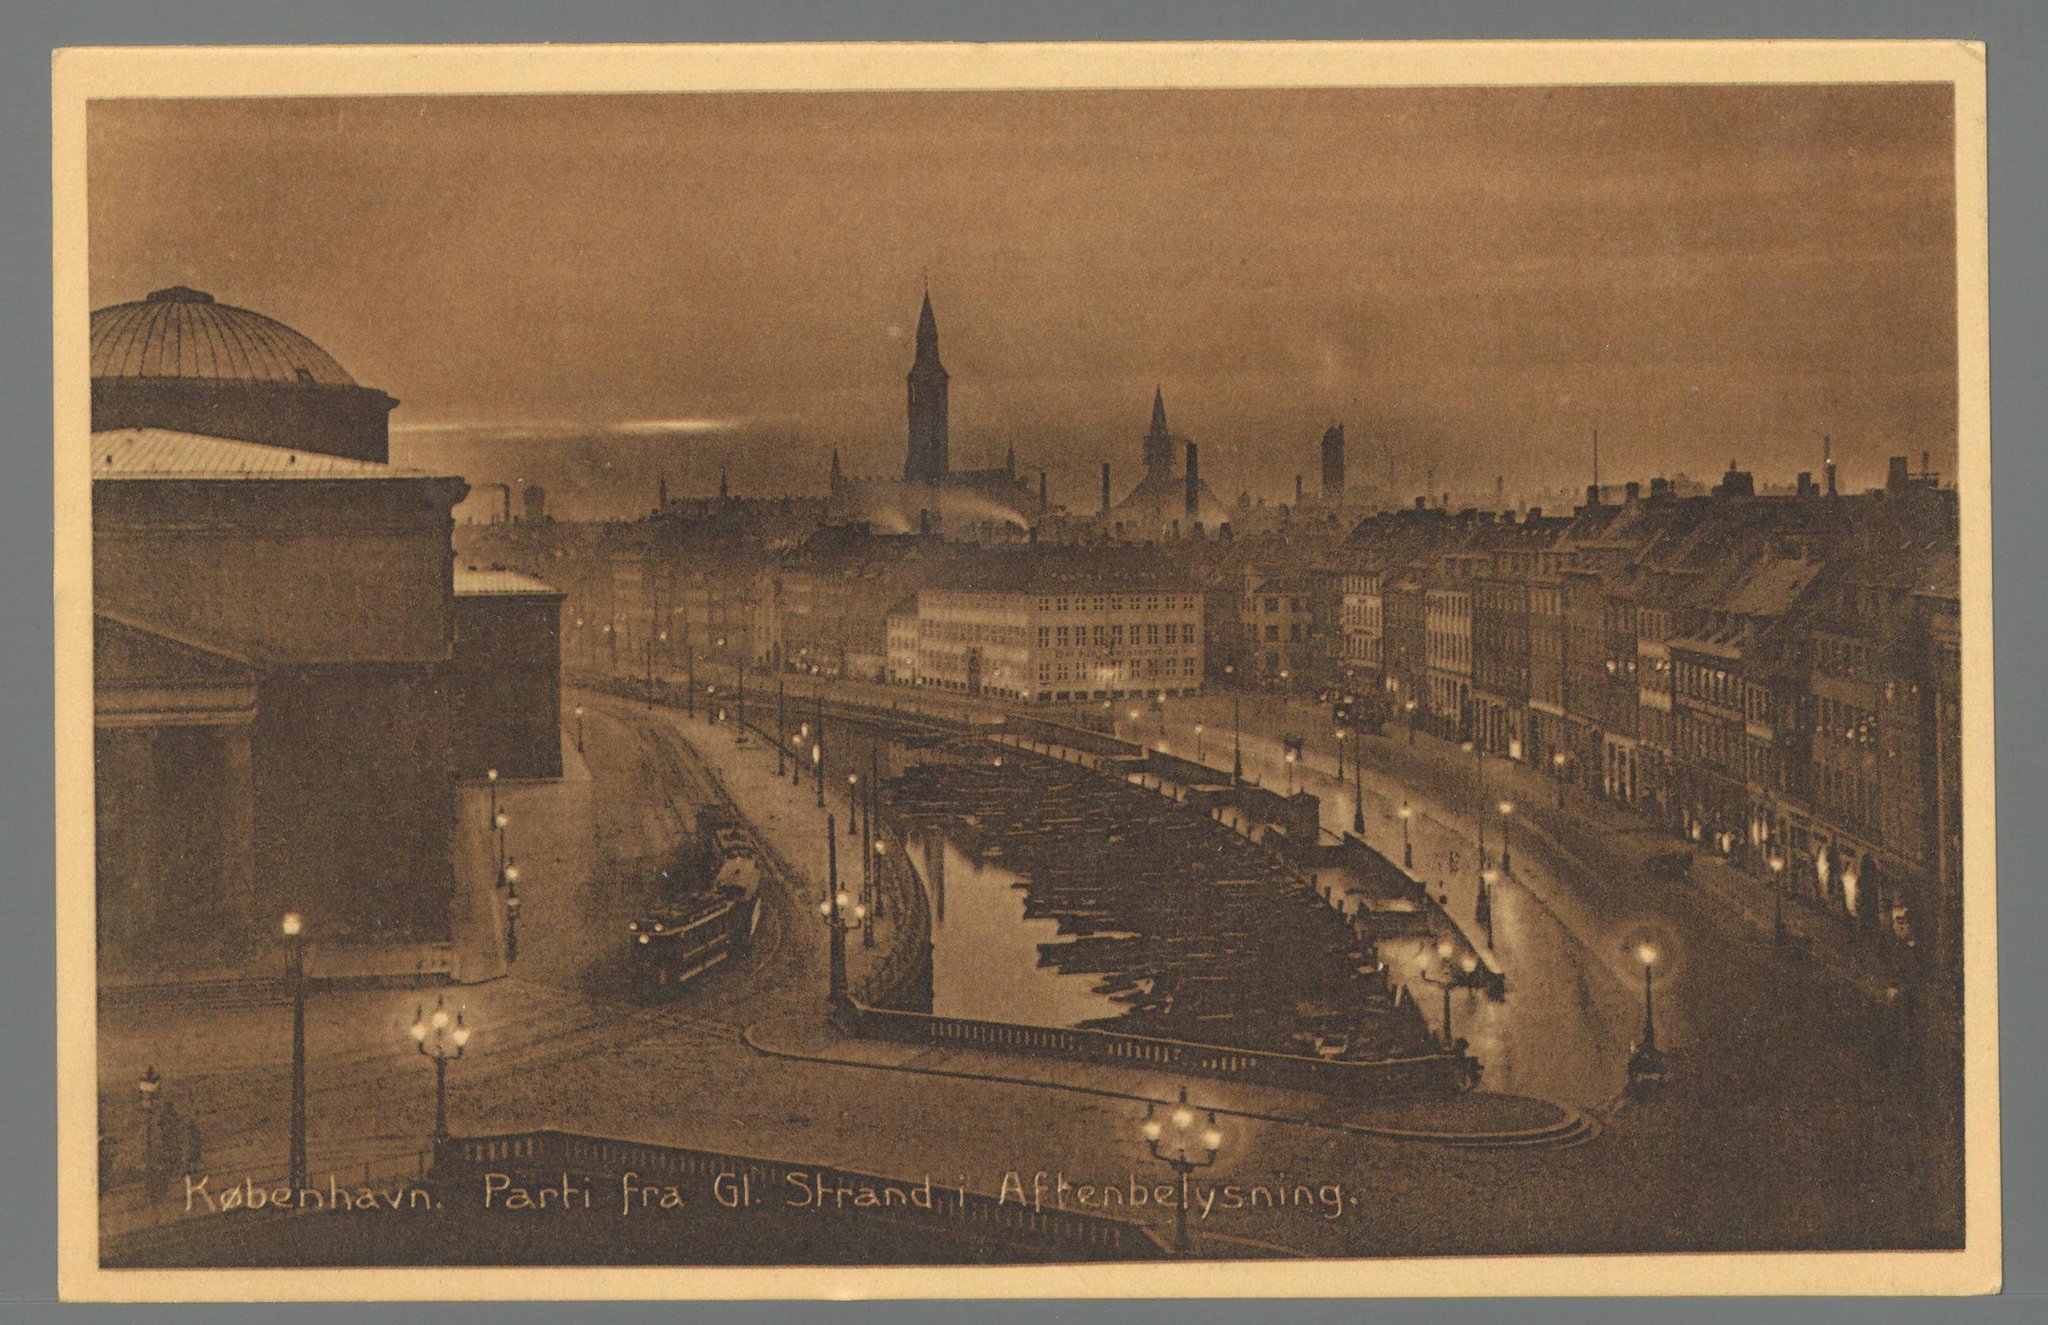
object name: photomechanical print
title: Köbenhavn. Parti fra Gl. Strand i Aftenbelysning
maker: Anonymous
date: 1906-1920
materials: cardboard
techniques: photograph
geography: copenhagen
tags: canal, night, prospect of city, town panorama, silhouette of city (+ city(-scape) with figures, staffage), copenhagen (city)